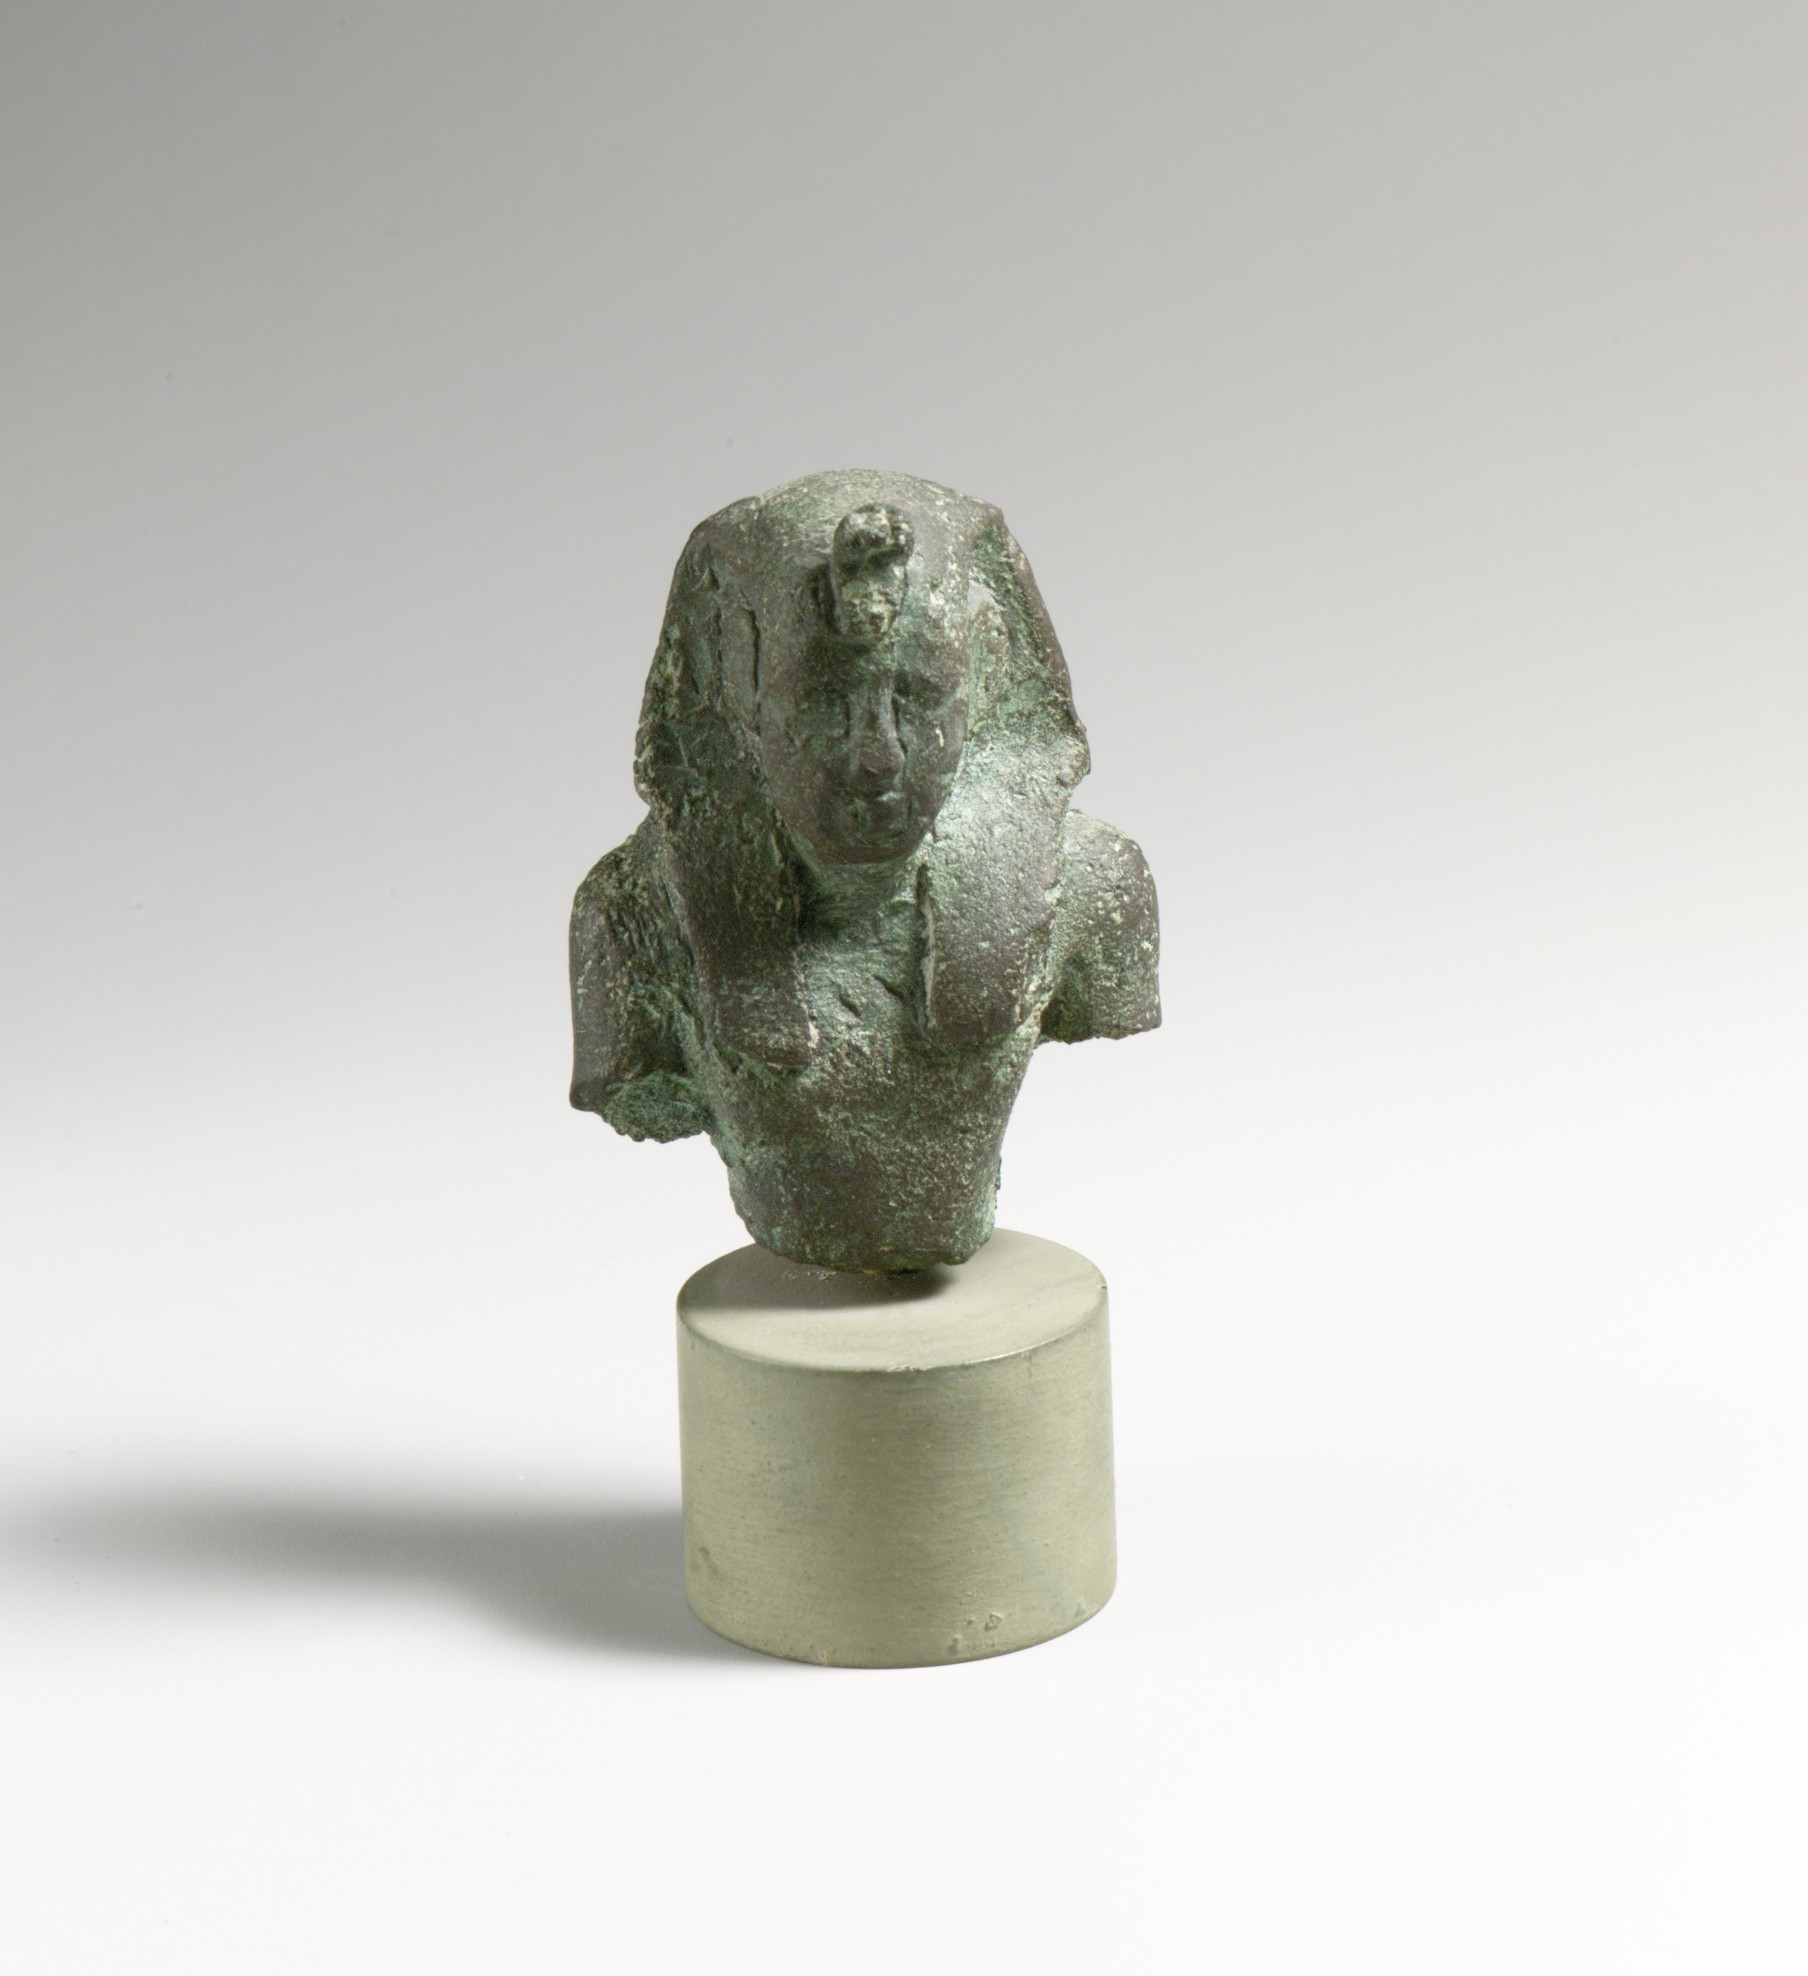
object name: portrait head of a pharaoh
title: Bronze portrait head of a pharaoh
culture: egyptian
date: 664-631 BCE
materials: bronze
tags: heads,men